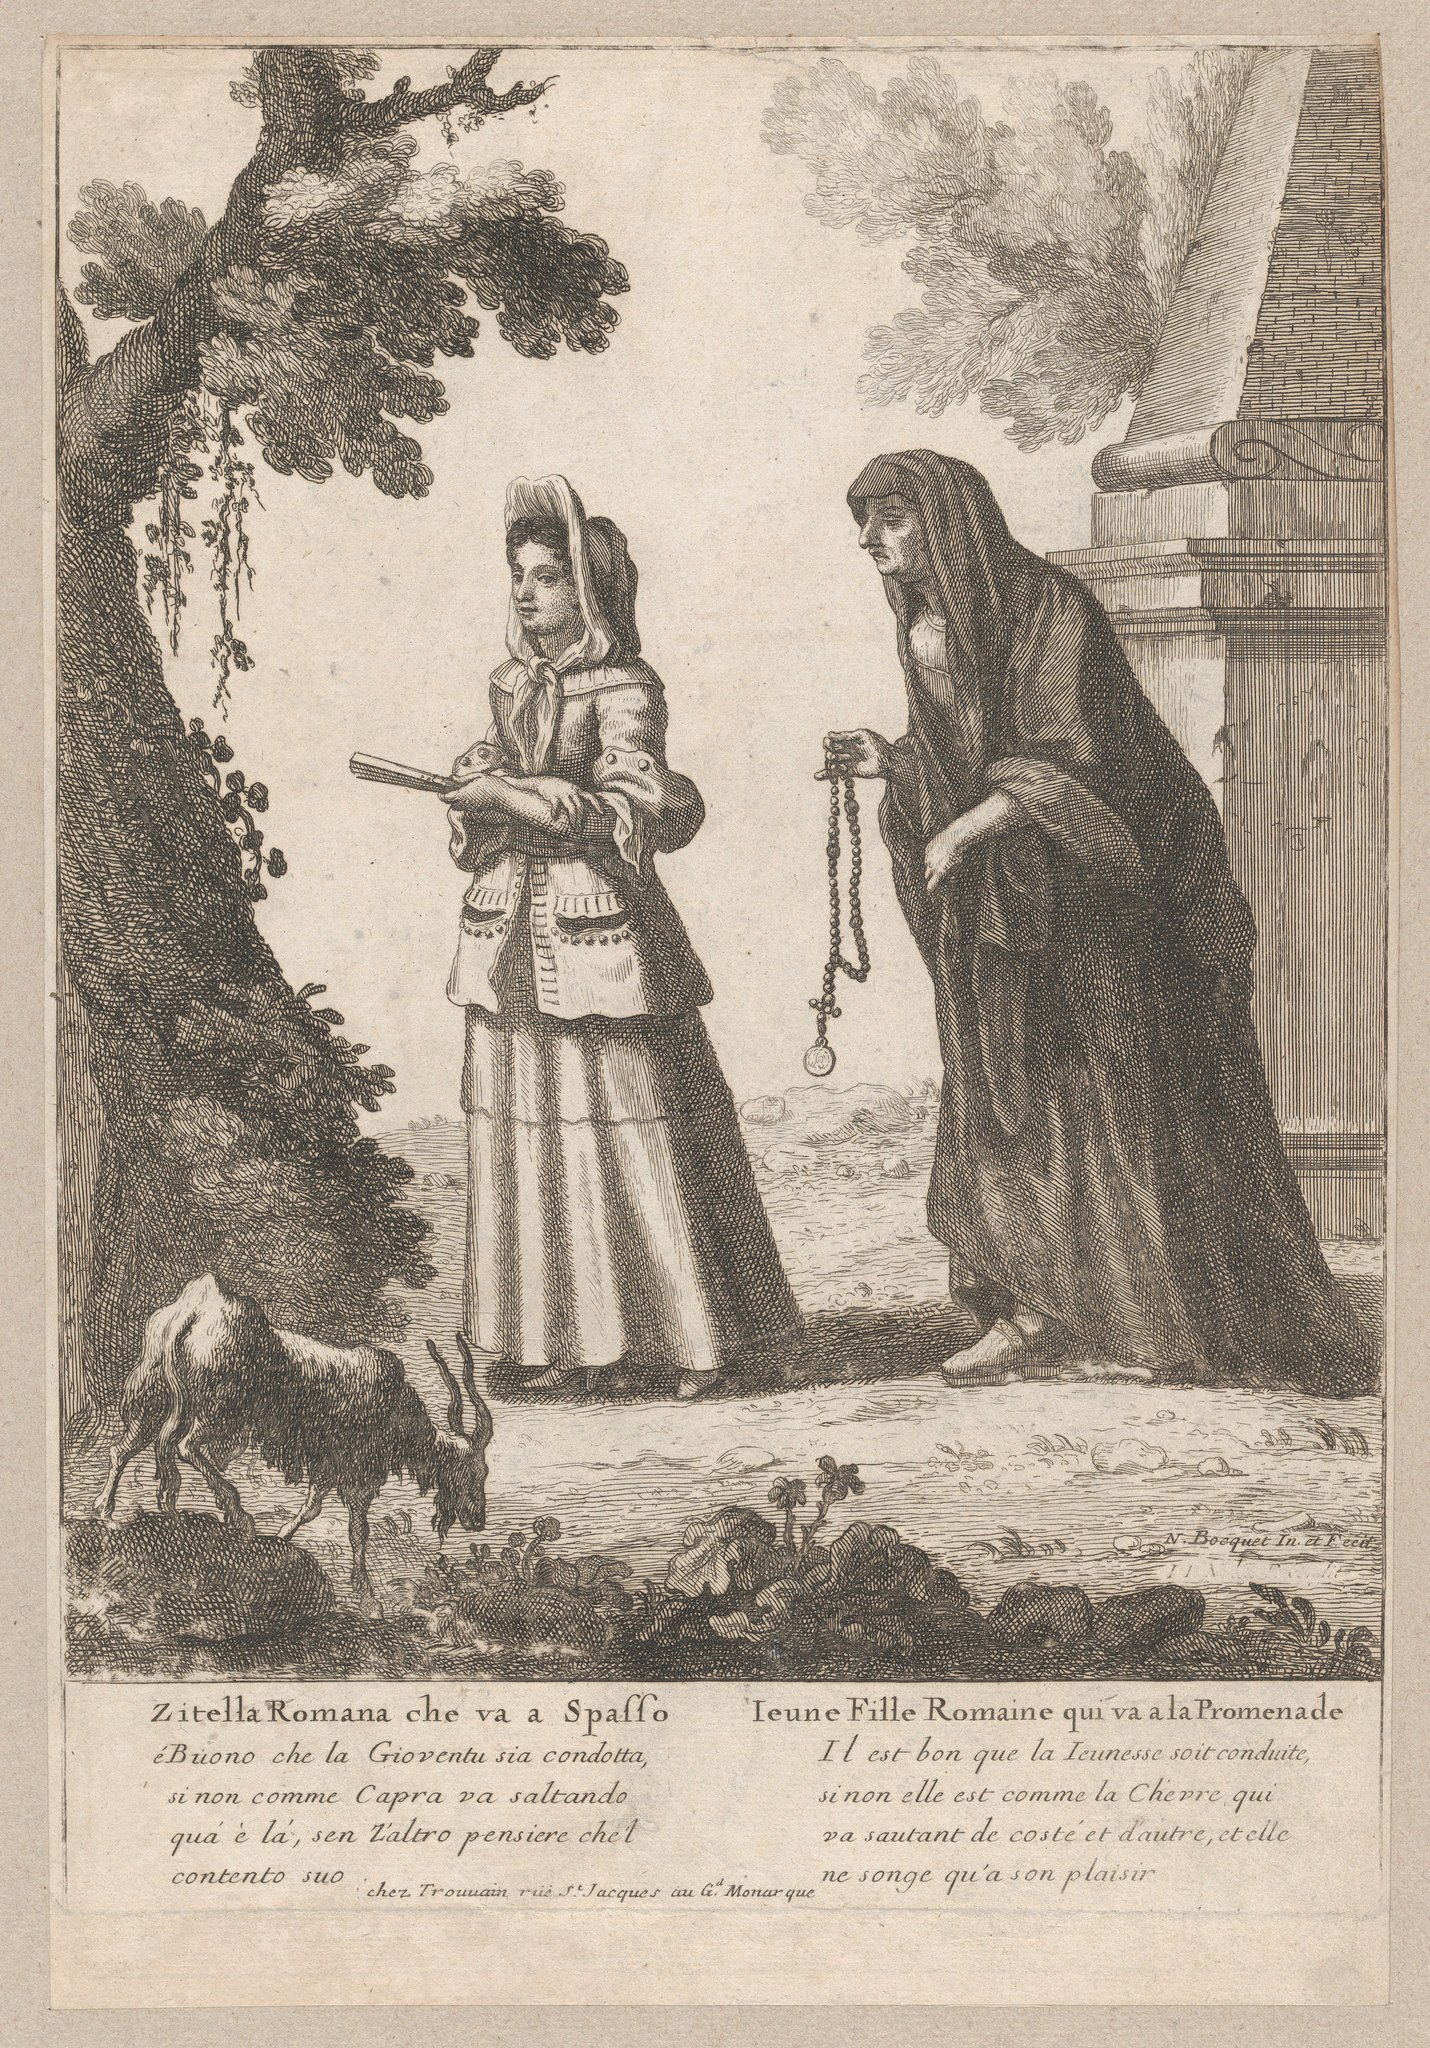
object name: print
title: Young Roman Girl Going for a Walk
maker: nicholas boucquet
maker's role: artist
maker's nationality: french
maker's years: 1648-1700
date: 1648-1700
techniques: engraving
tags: girls,women,walking,goats